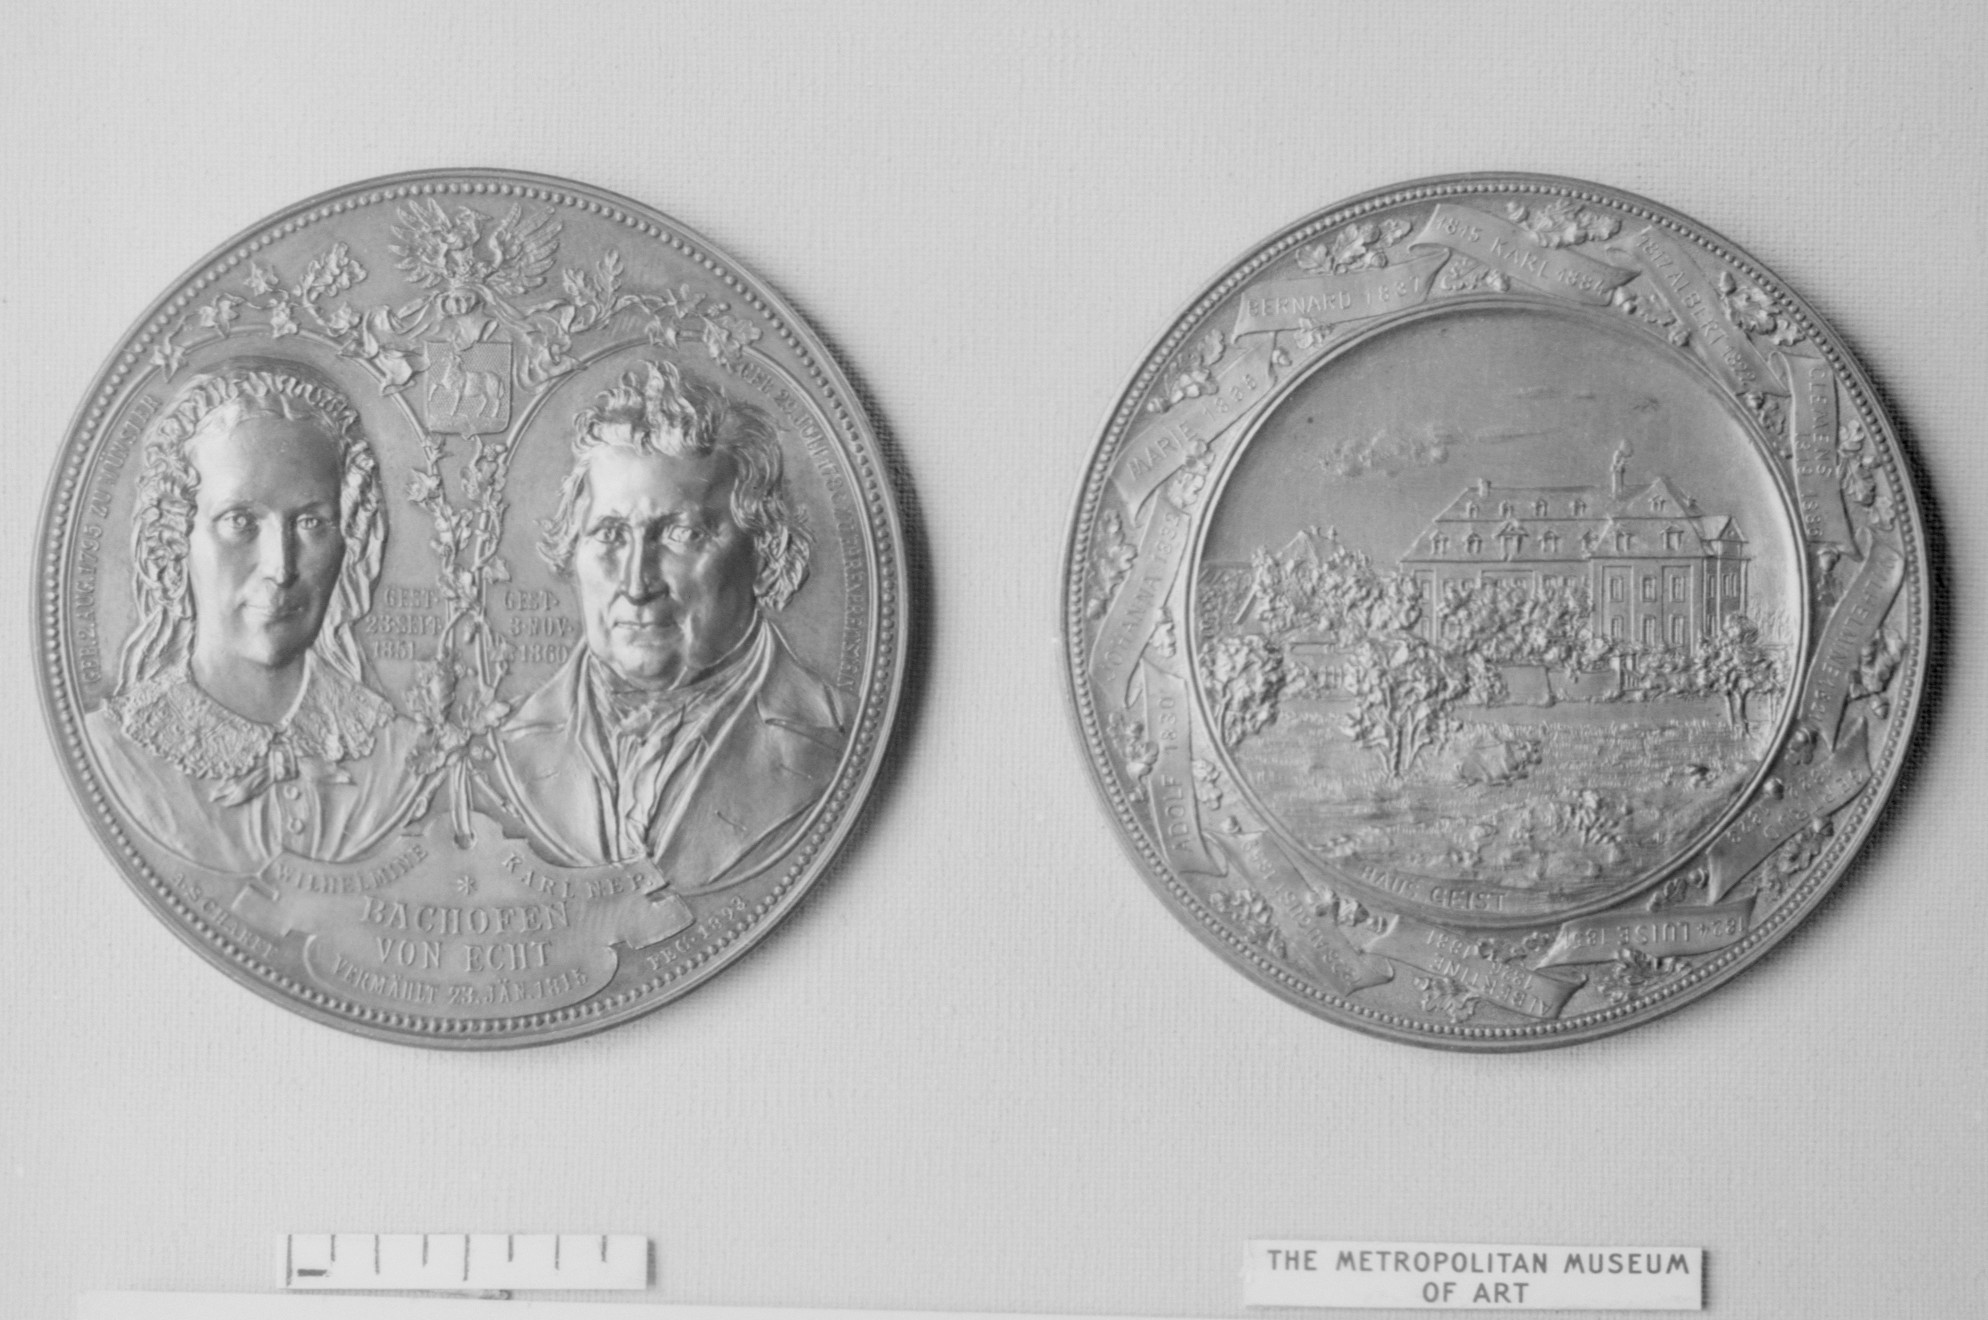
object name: medal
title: In Memory of Karl Nepomuk and Wilhelmine Bachofen von Echt, and Their Family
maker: anton scharff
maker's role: artist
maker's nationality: austrian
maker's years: 1845-1903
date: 1893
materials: gilt bronze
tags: men,portraits,women